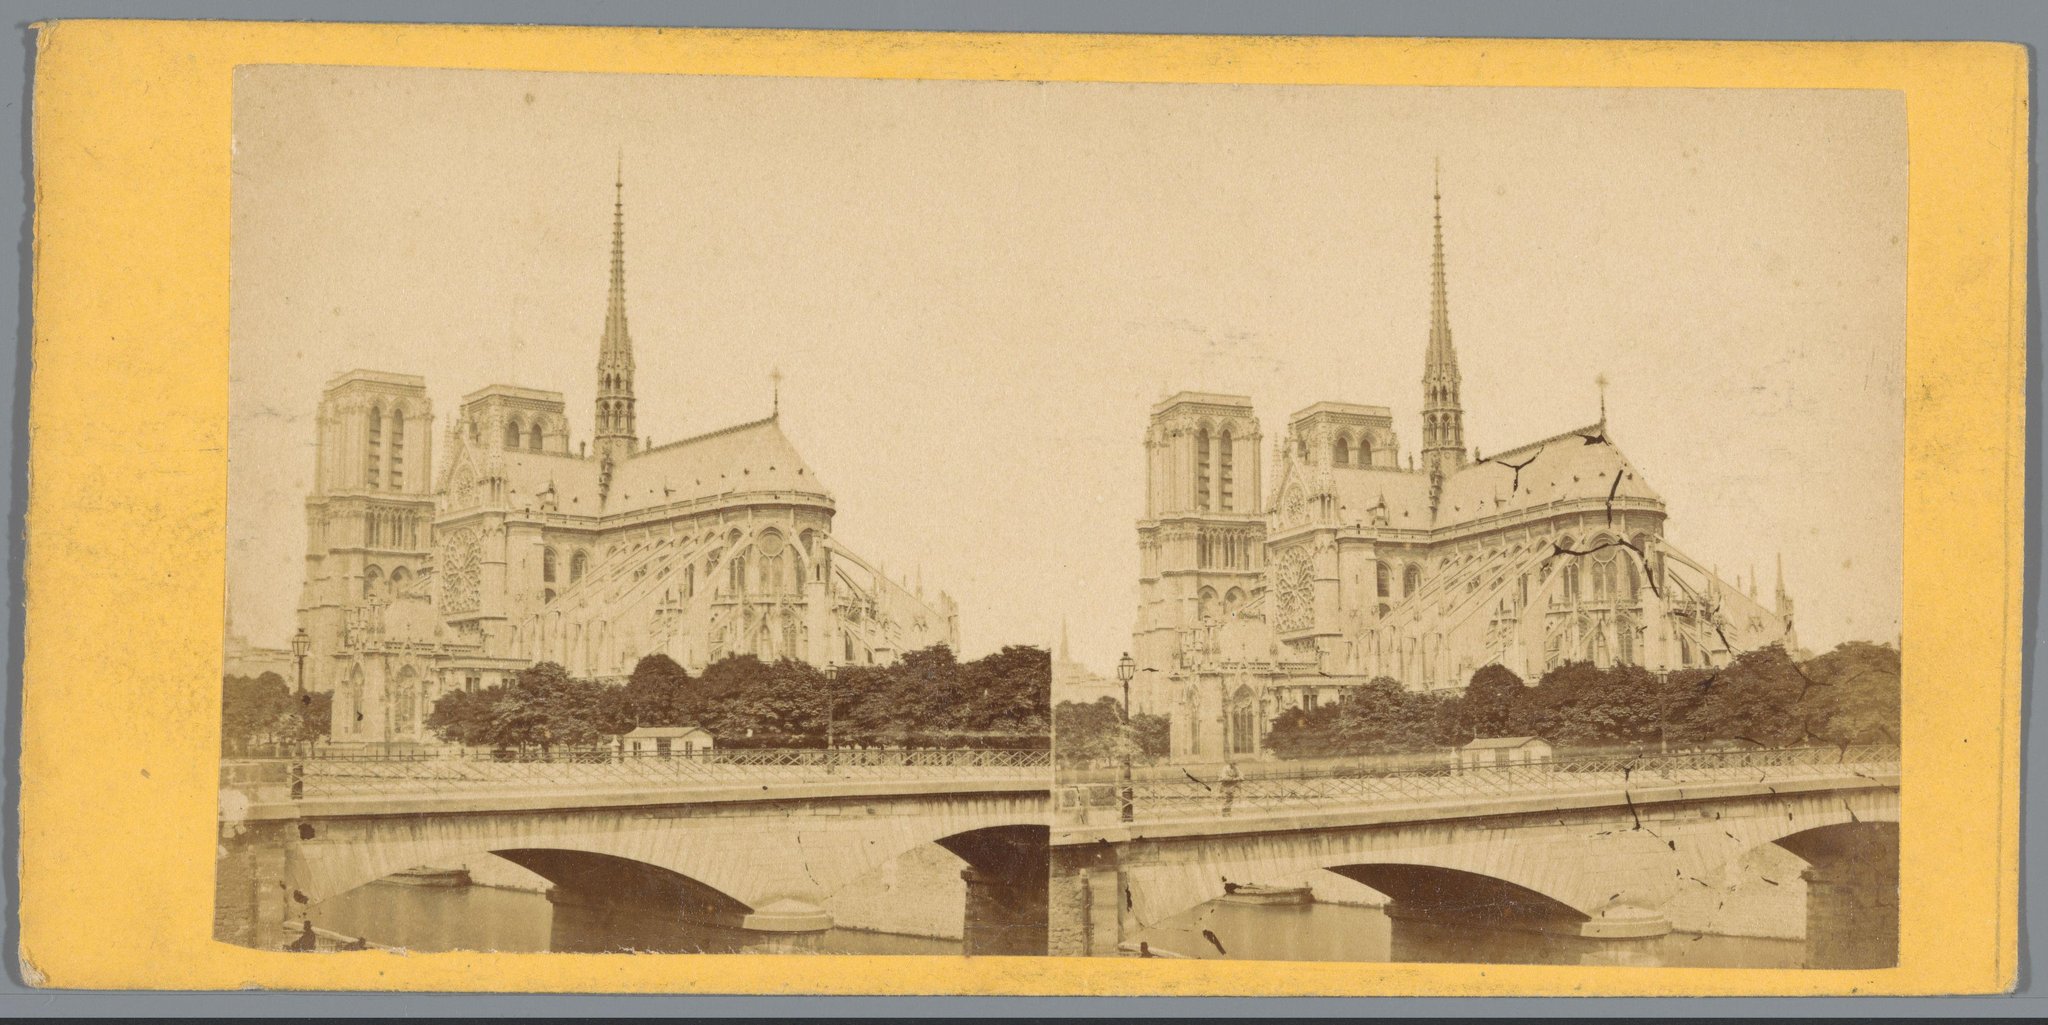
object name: stereograph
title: Gezicht op de Notre-Dame in Parijs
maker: Anonymous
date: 1850-1880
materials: cardboard, photographic support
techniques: albumen print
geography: paris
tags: church (exterior)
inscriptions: inscription: ‘Paris, Notre Dame’